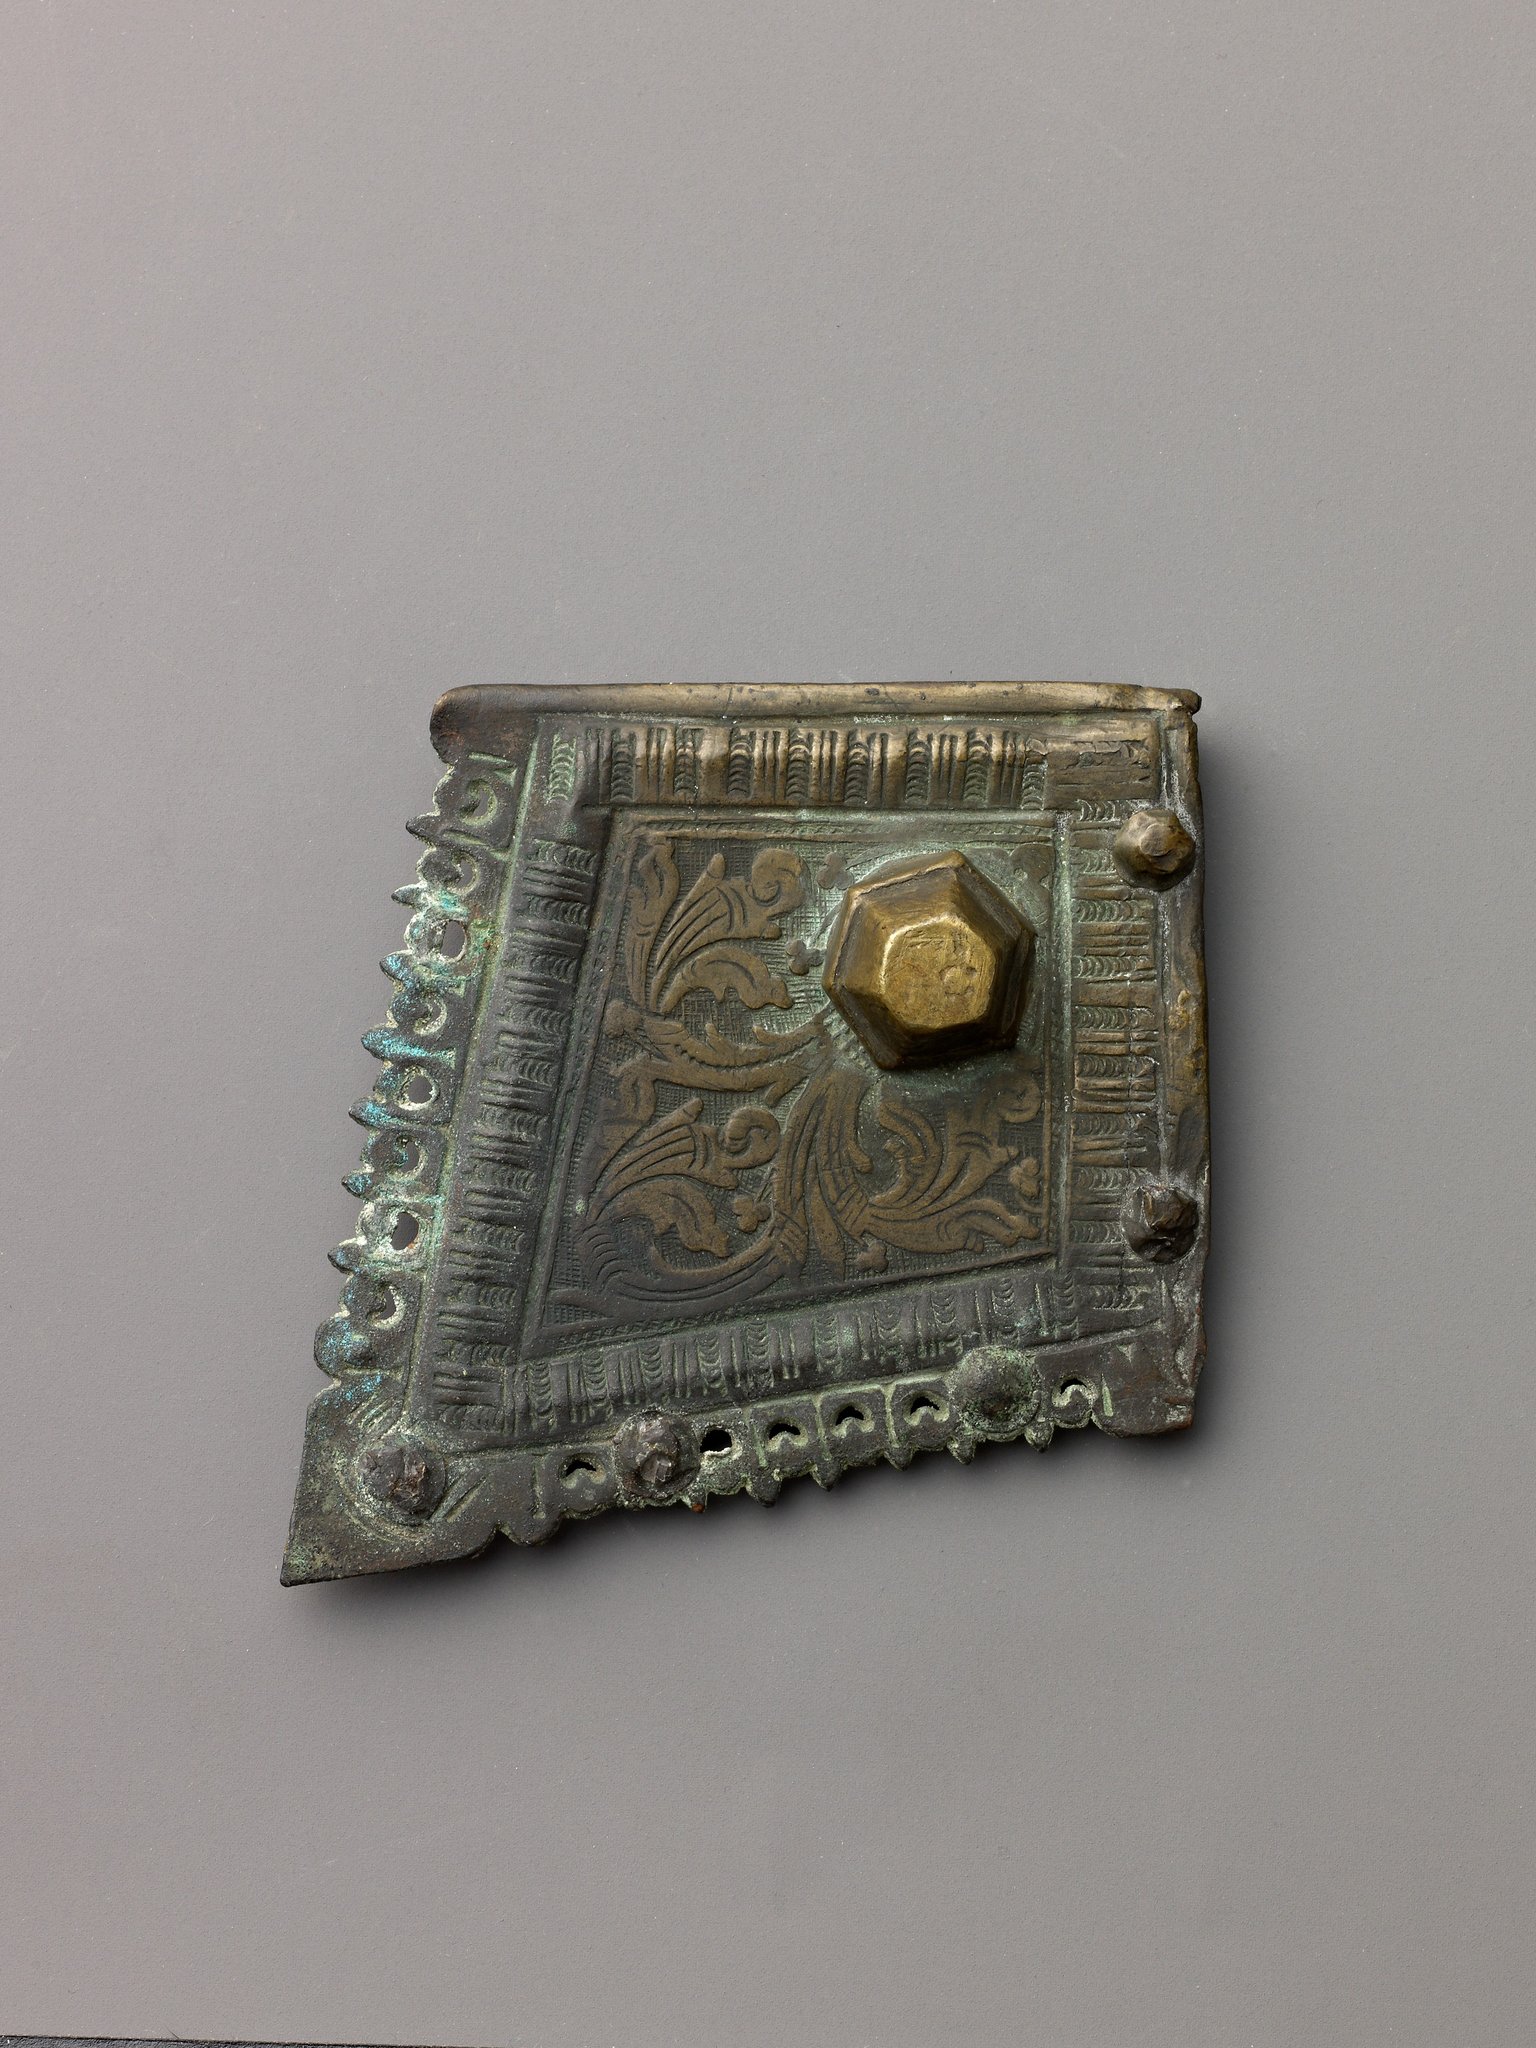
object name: book binding mount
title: Engraved book binding mount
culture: italian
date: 1470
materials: copper